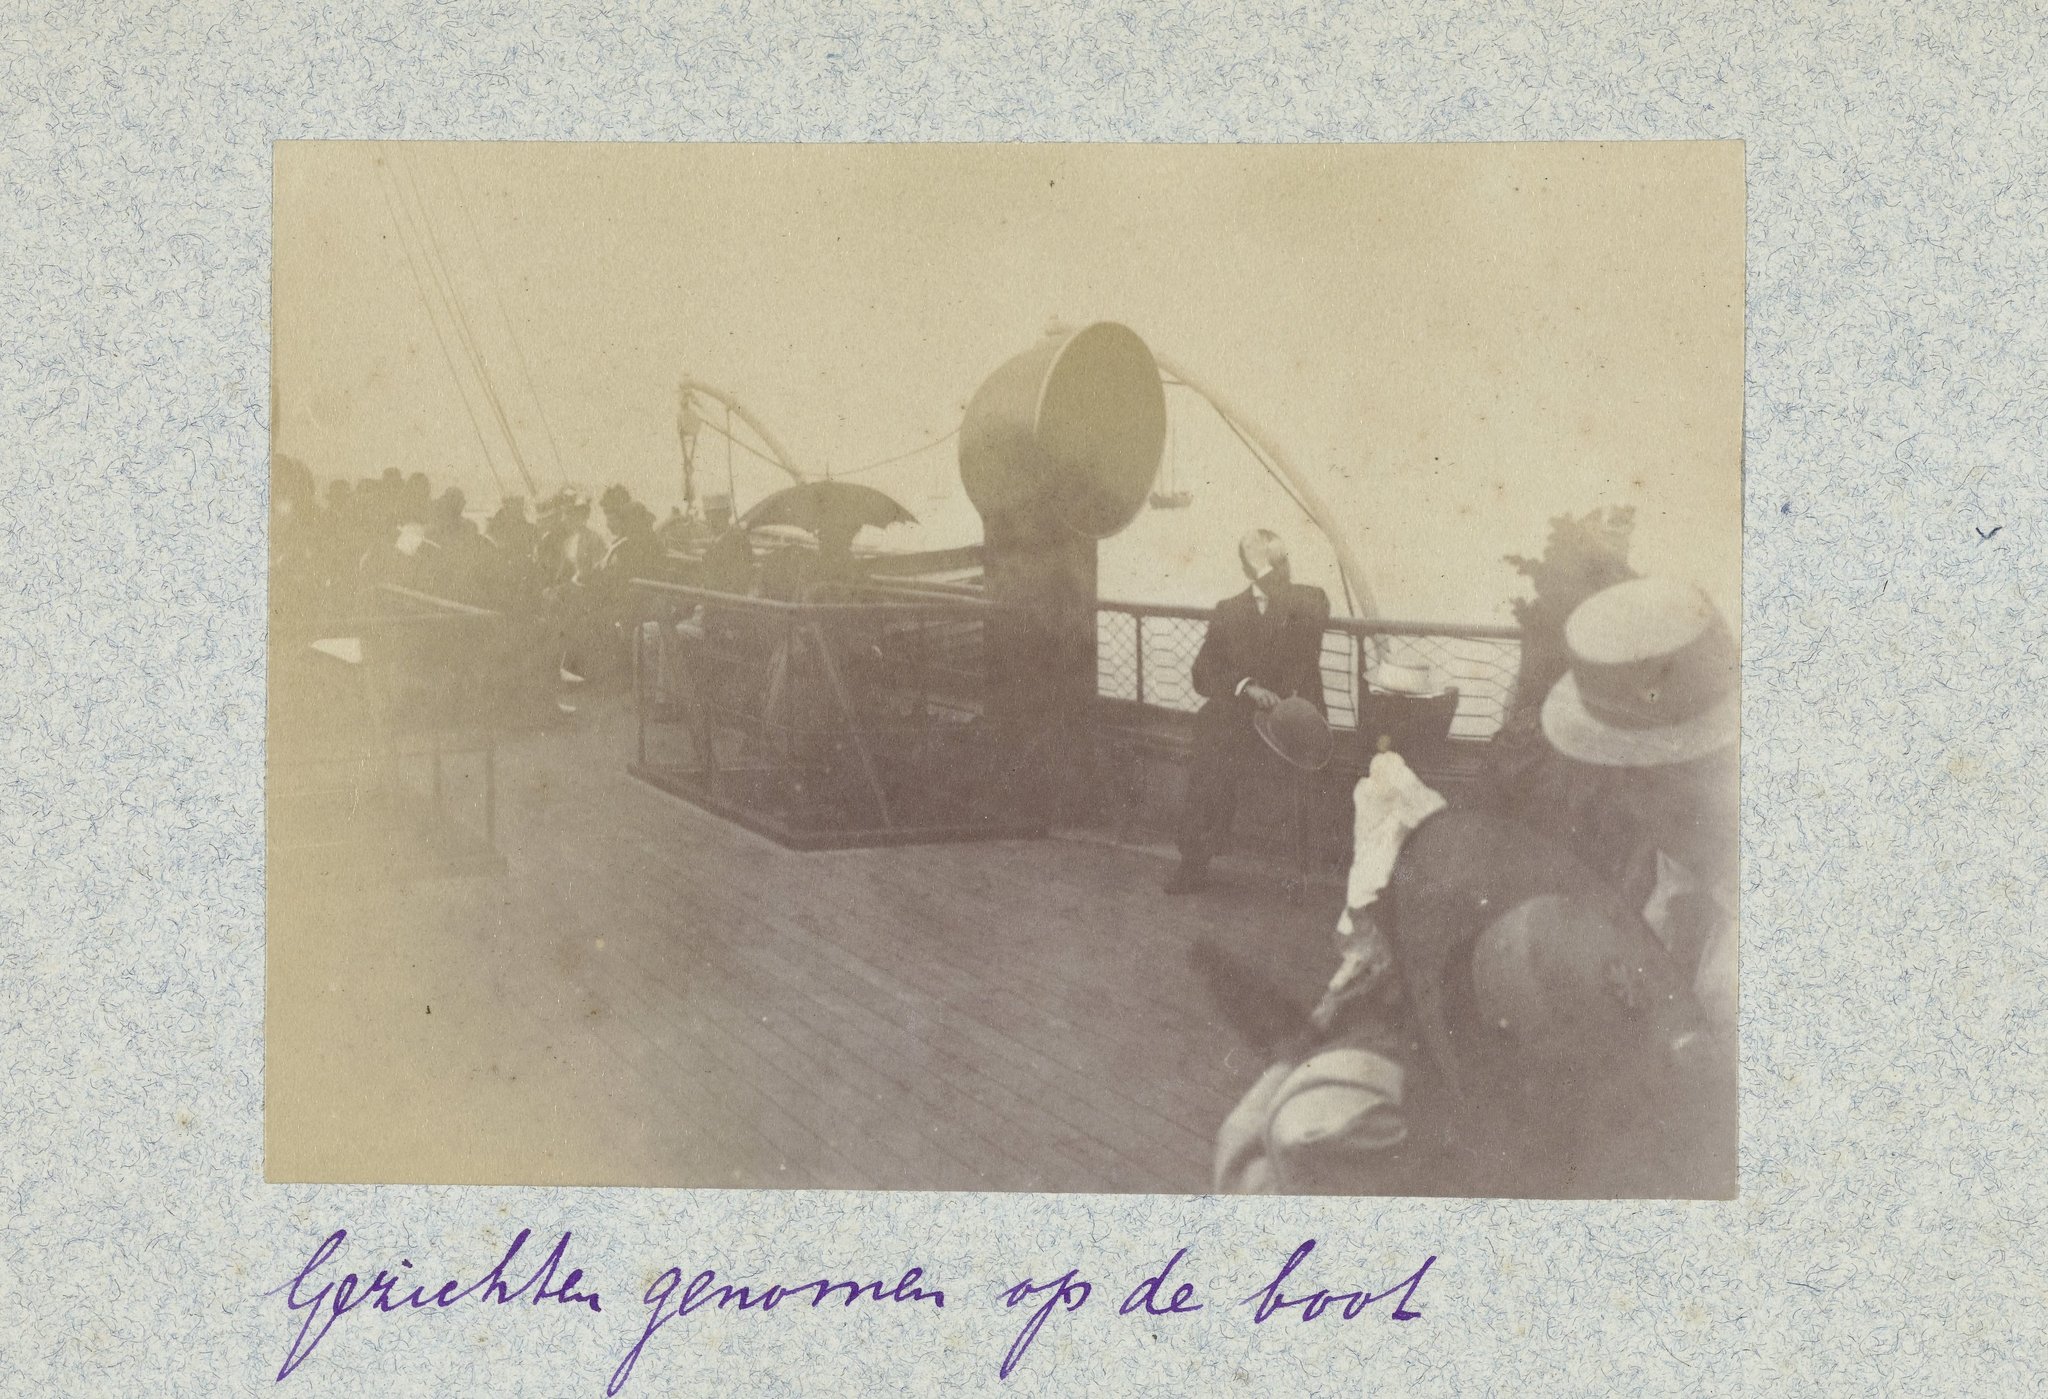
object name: photograph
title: Passagiers op het dek van de boot tussen Ryde en Portsmouth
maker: henry pauw van wieldrecht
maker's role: fotograaf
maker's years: 1863-1912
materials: cardboard, paper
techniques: albumen print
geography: great britain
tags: parts of ship's exterior: deck, passengers ~ ship, great britain